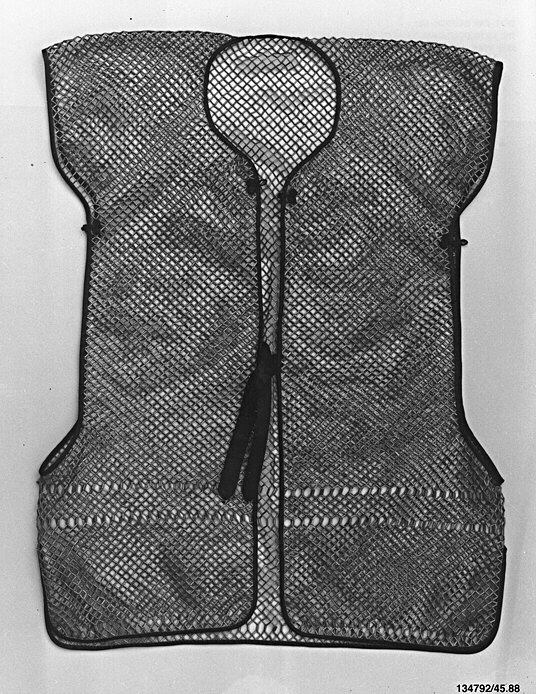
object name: sweatshirt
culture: chinese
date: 1801-1900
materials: bamboo, silk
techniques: lacquer